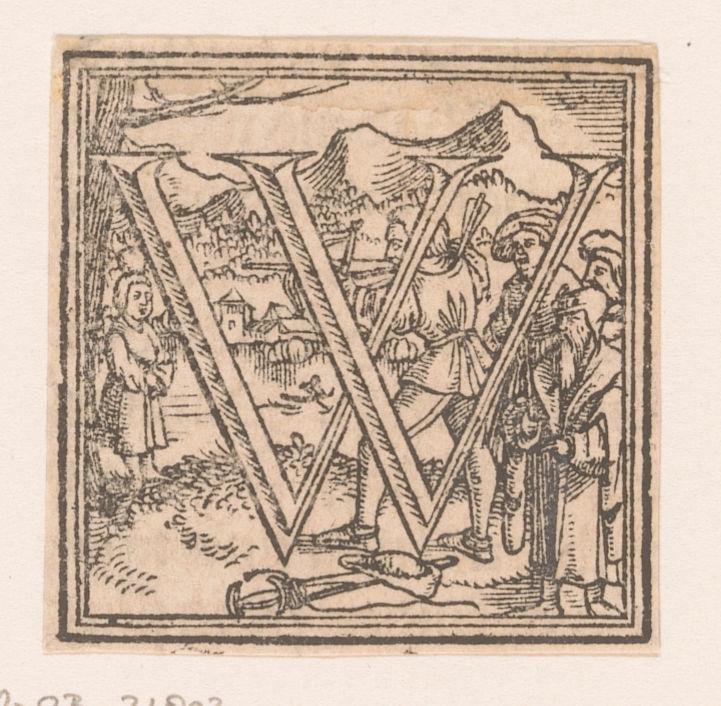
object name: book illustration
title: Versierde initialen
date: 1556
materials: paper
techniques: letterpress printing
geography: zurich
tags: william tell, initial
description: Prent afkomstig uit: Bibel, die gantze, das ist alle Bücher alts und news Testaments (...). Zürich: Johann Froschauer, 1556.